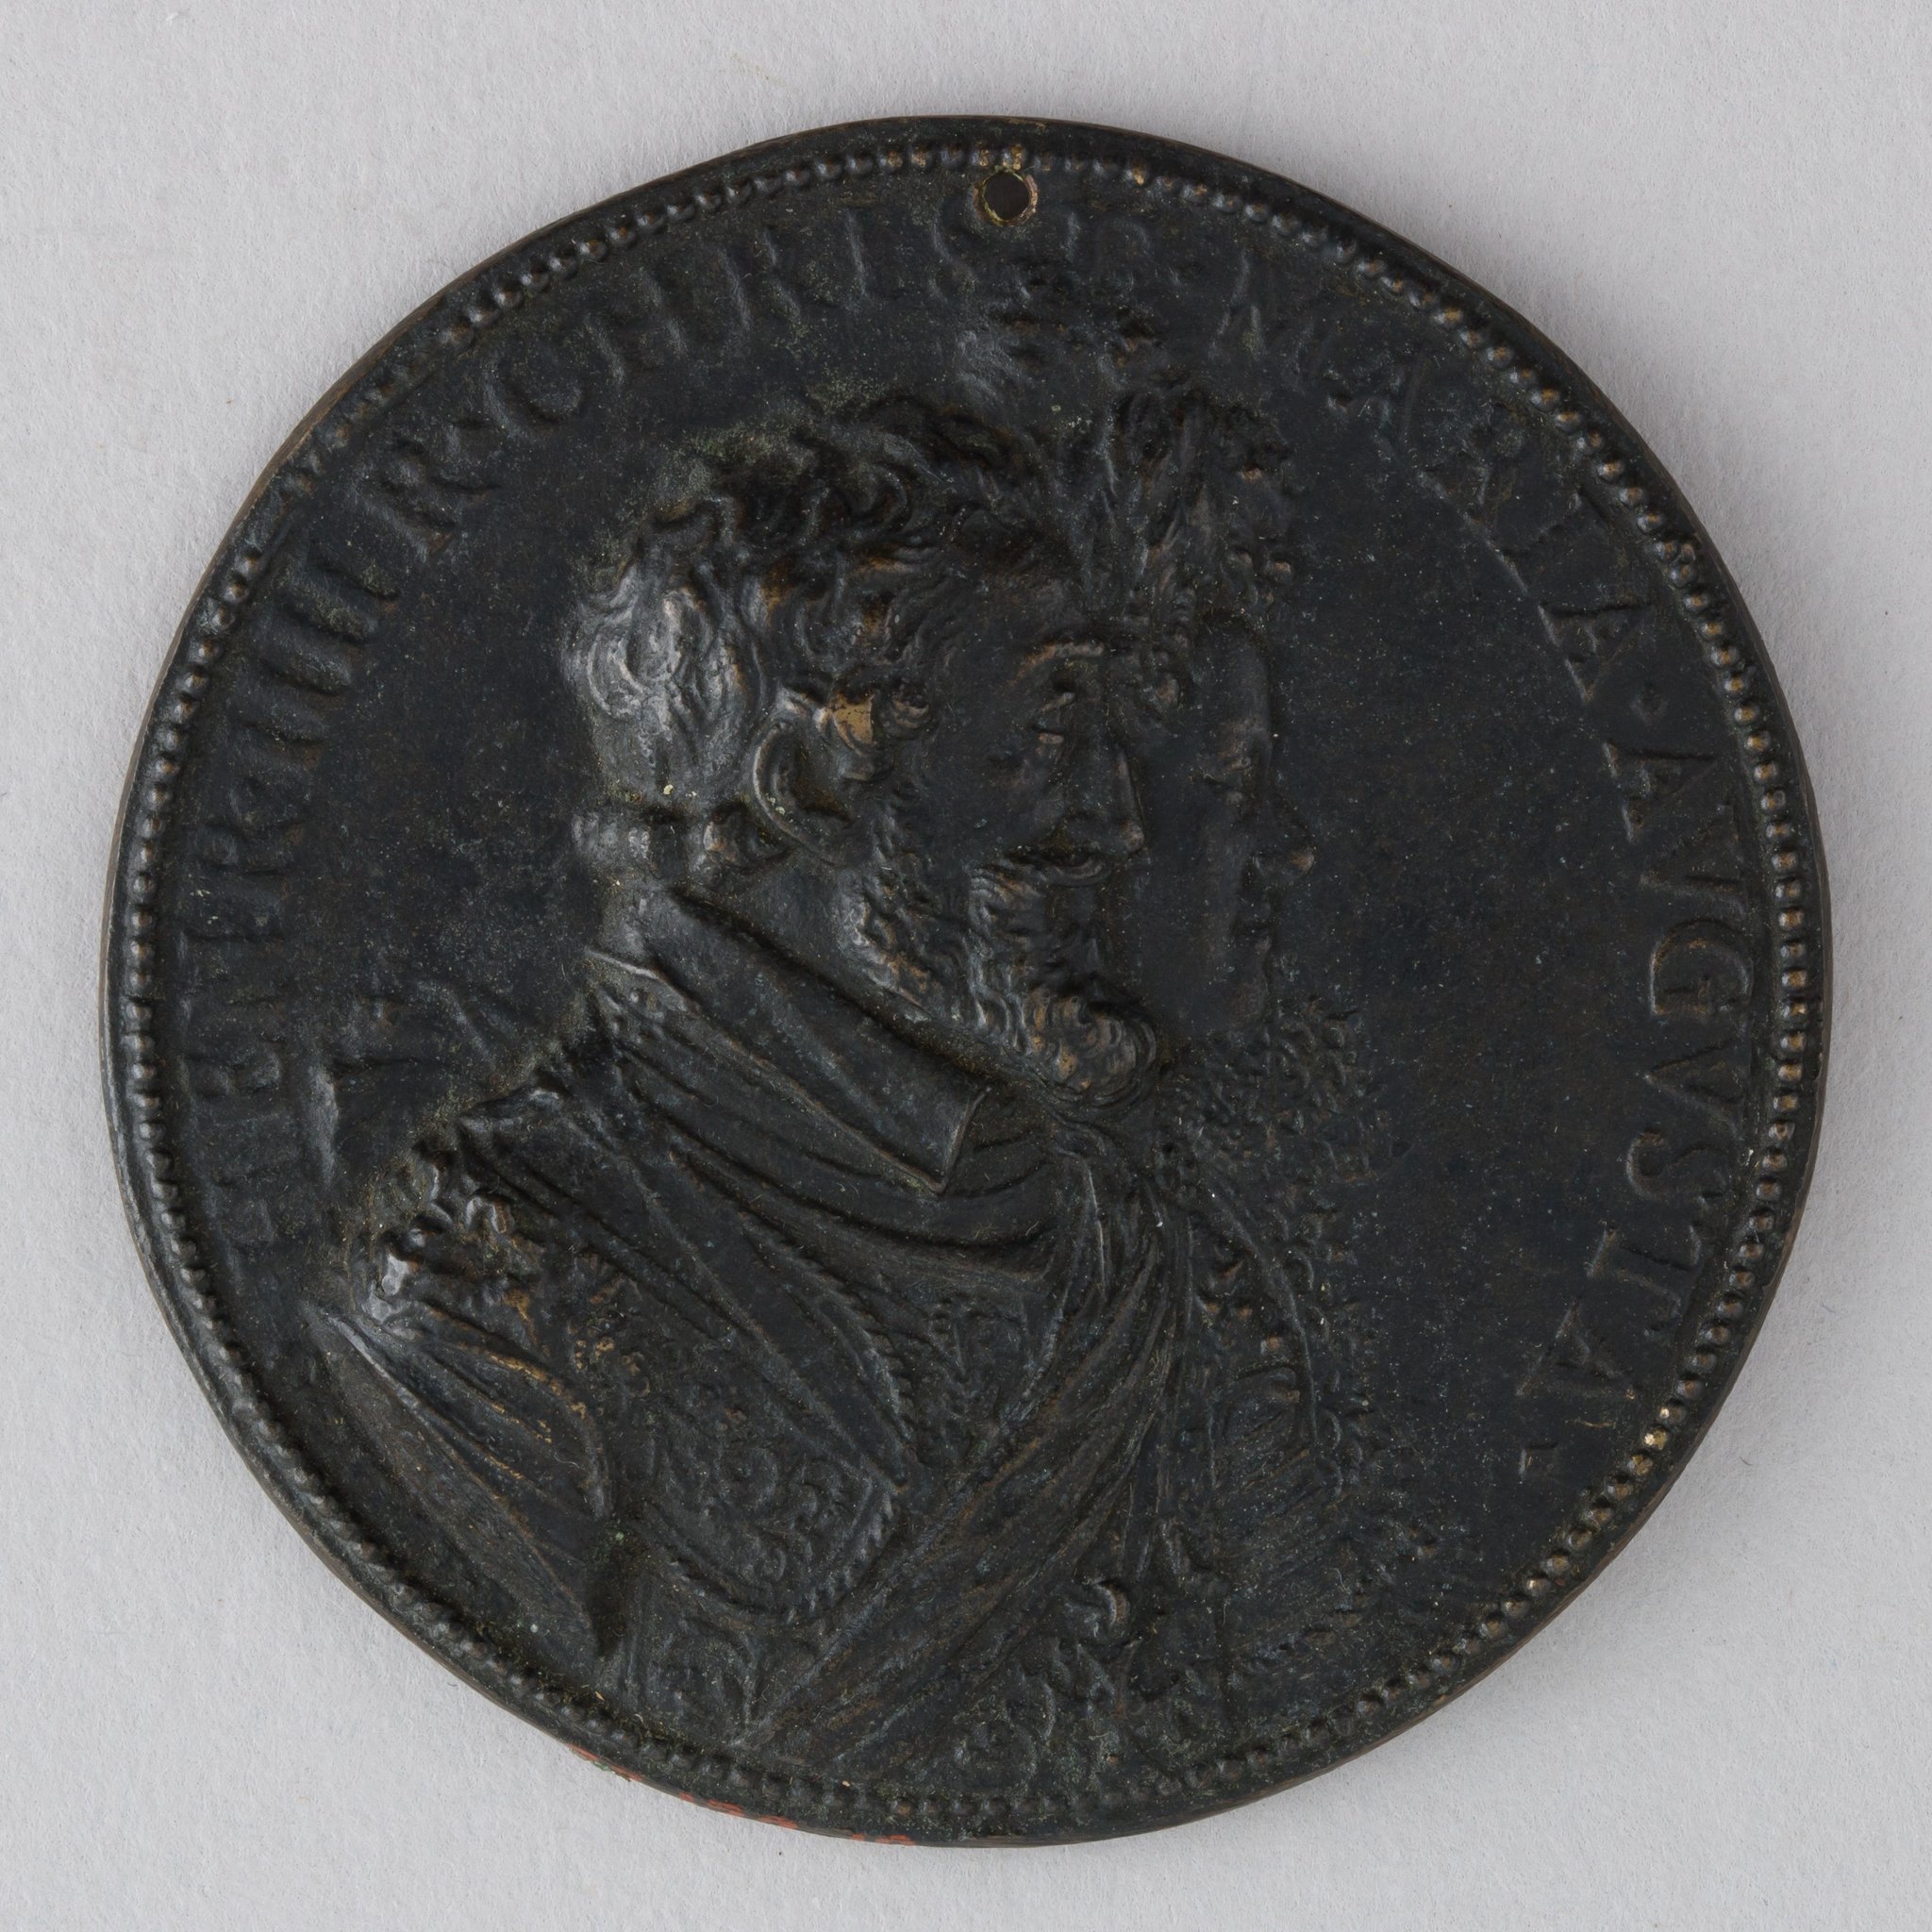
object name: medal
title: Medal Showing Henry IV of France (b. 1553, r. 1589–1610) and Marie de Médicis (1573–1642)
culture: french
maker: guillaume dupré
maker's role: artist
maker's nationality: french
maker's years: 1579-1640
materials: bronze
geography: france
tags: men,profiles